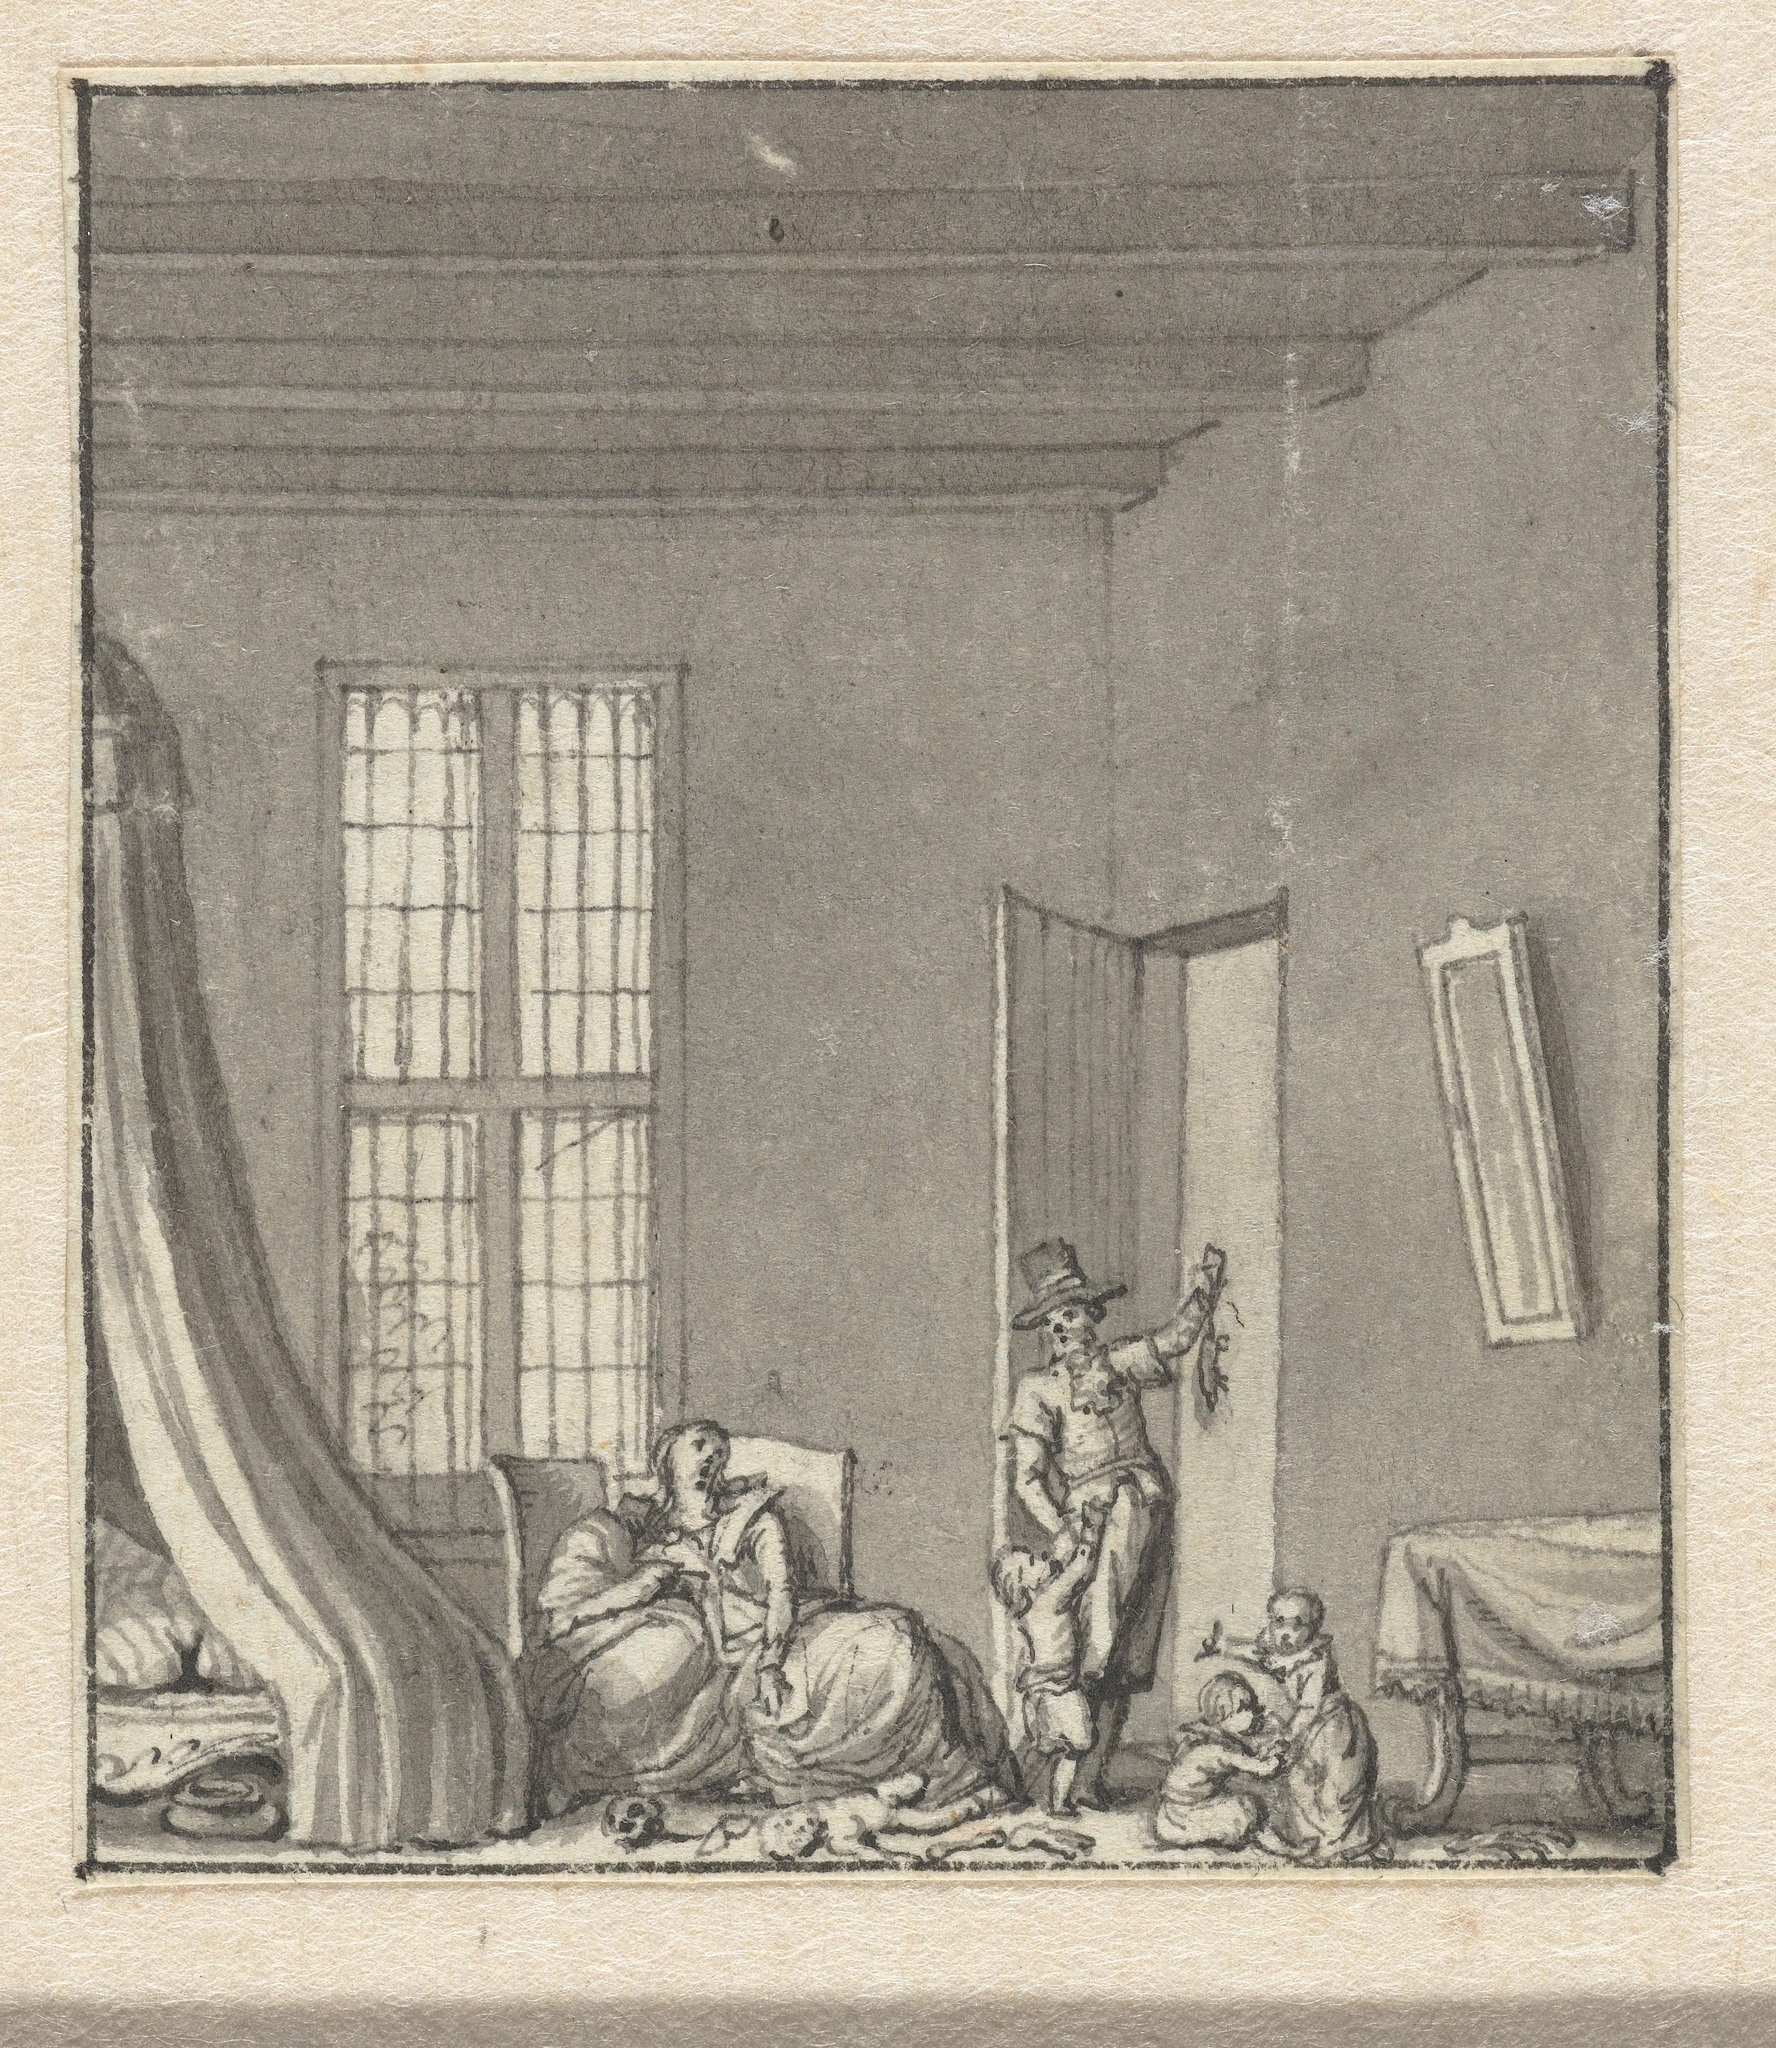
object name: design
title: In 't Jaar 1573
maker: Anonymous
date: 1789-1810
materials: ink, paper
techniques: brush, pen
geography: netherlands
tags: starvation, famine, leiden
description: Hongersnood in een gezin tijdens het beleg van Leiden, 1573.